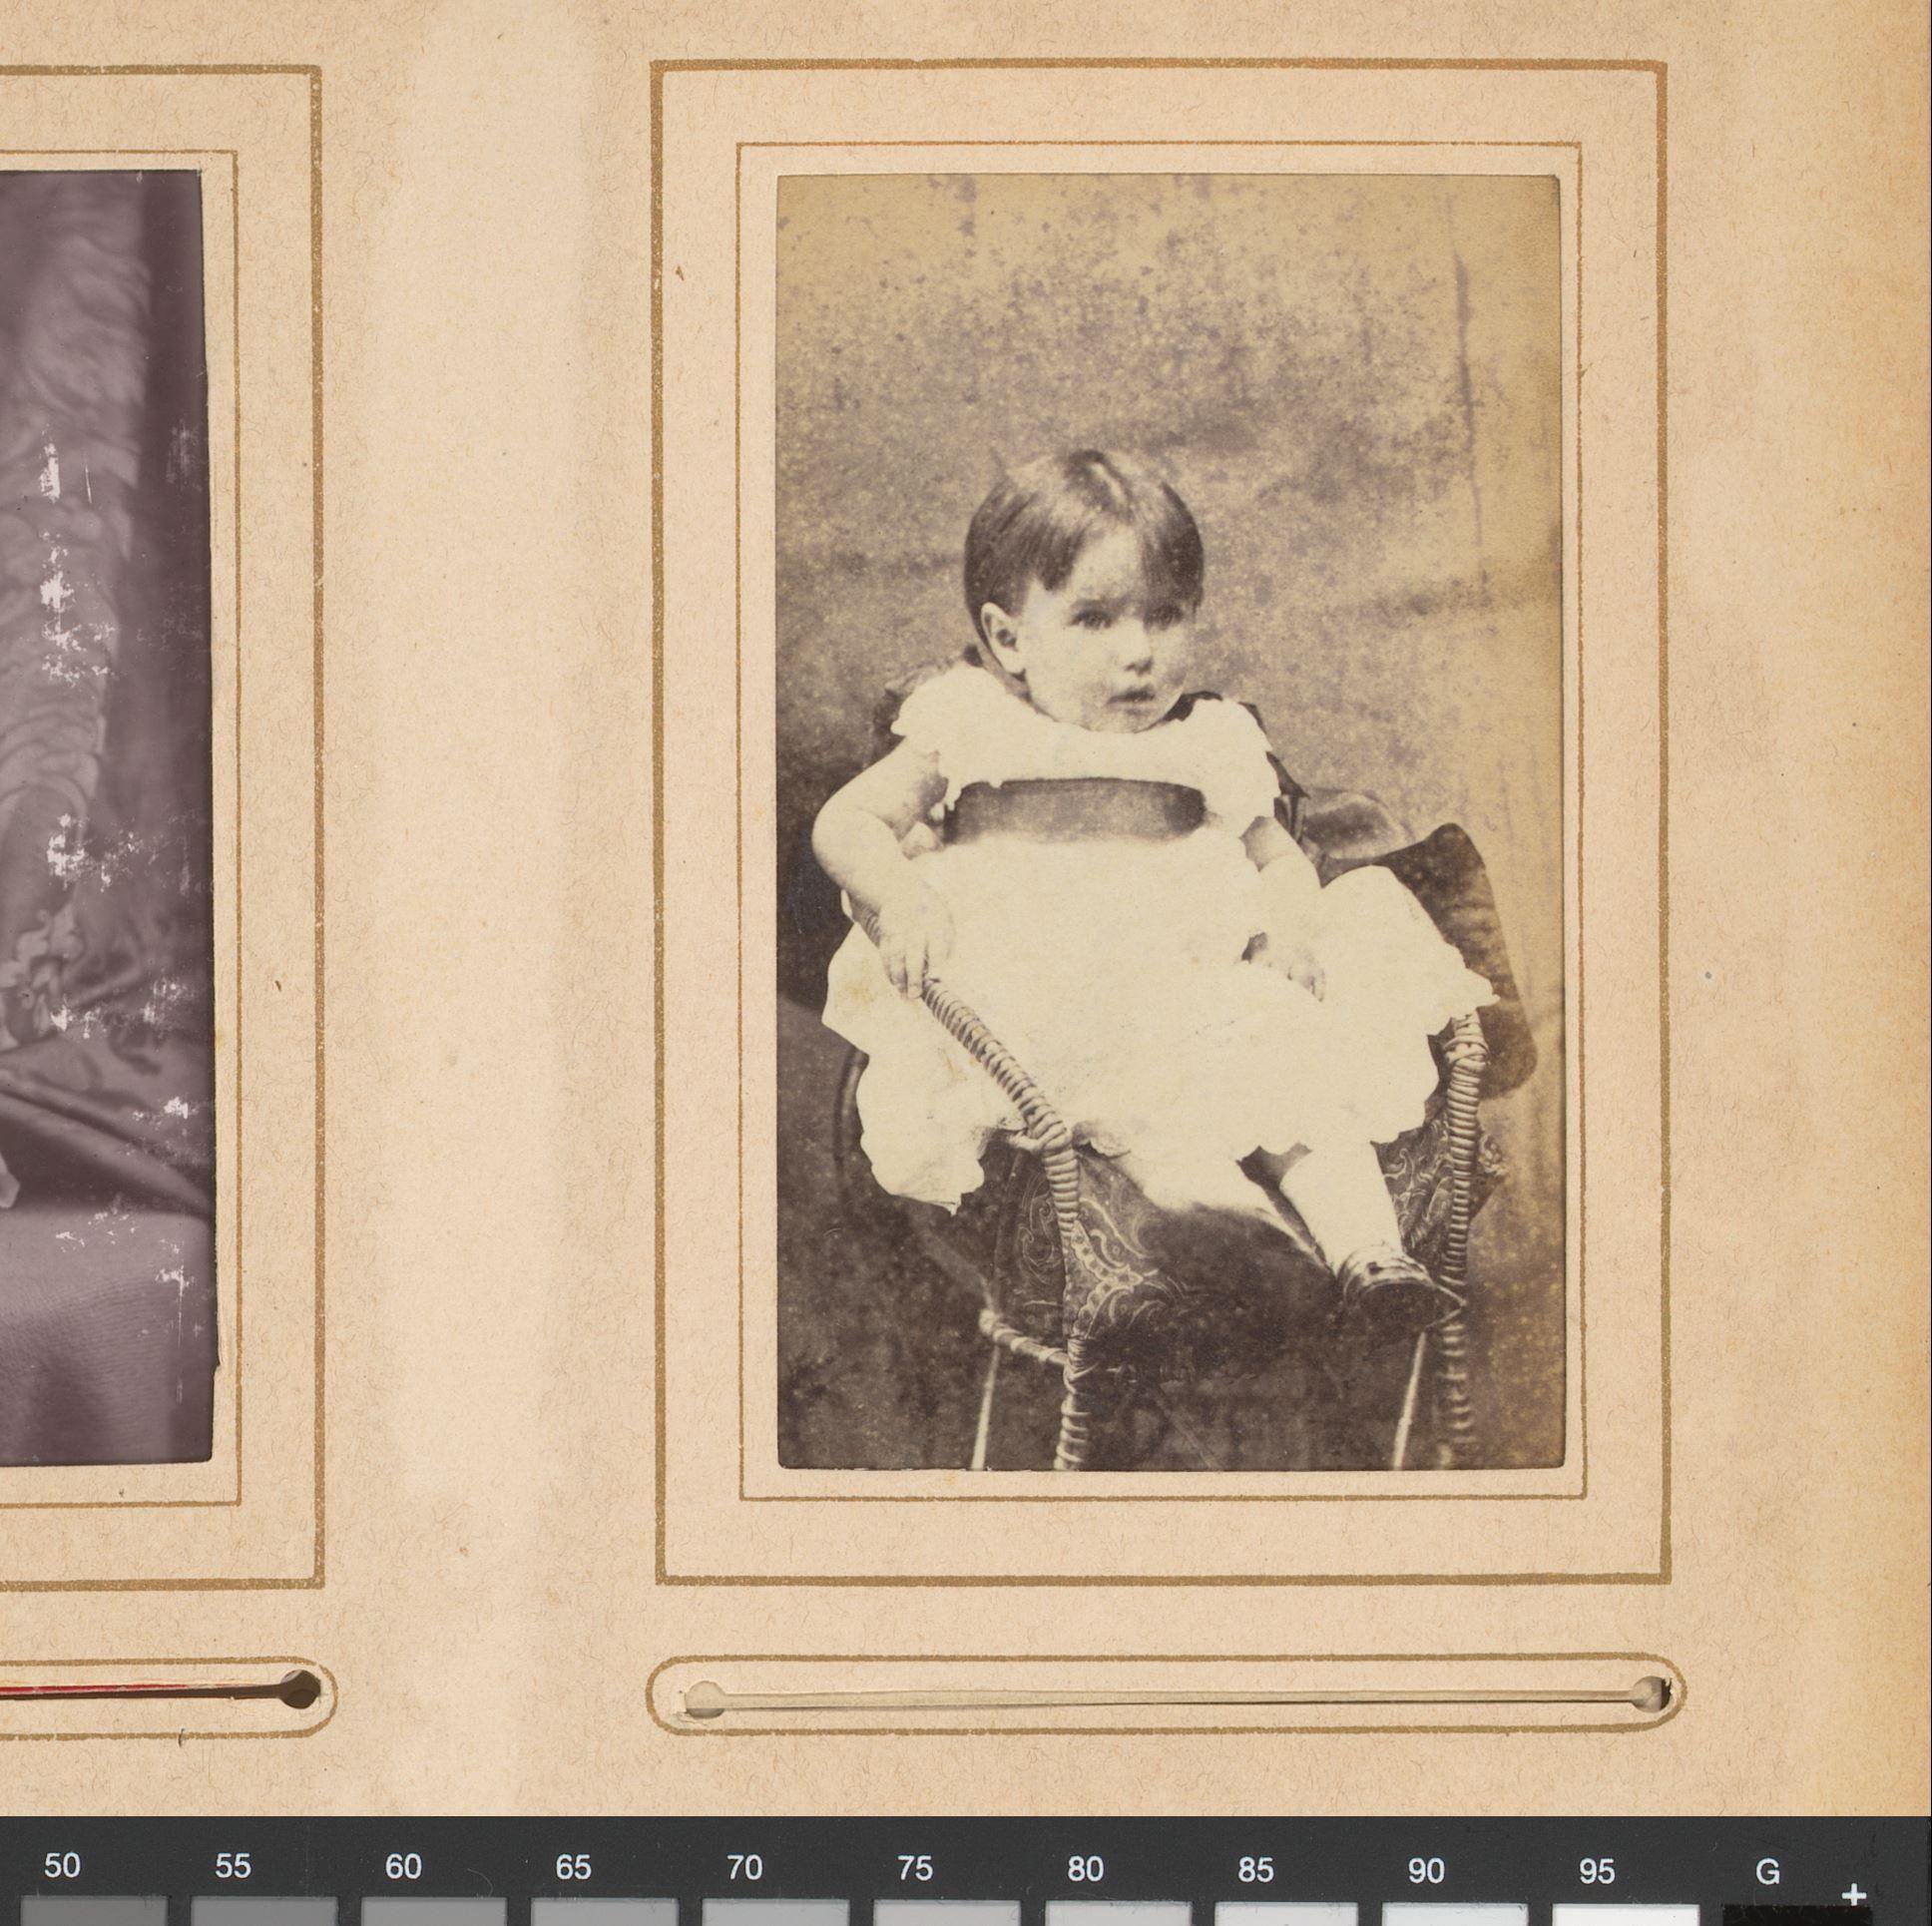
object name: photograph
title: Portret van een kind, zittend in een stoel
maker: f.h. secourable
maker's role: fotograaf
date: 1878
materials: cardboard, photographic support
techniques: albumen print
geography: essex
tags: sitting figure - aa - female human figure, child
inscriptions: inscription: ‘Photographed by/ F.H. Secourable/ institute of photography next the bank/ High Street/ Southend/ Essex’, annotation: ‘taken. Sept. 10th 1878/ age 1 year. 2 weeks’